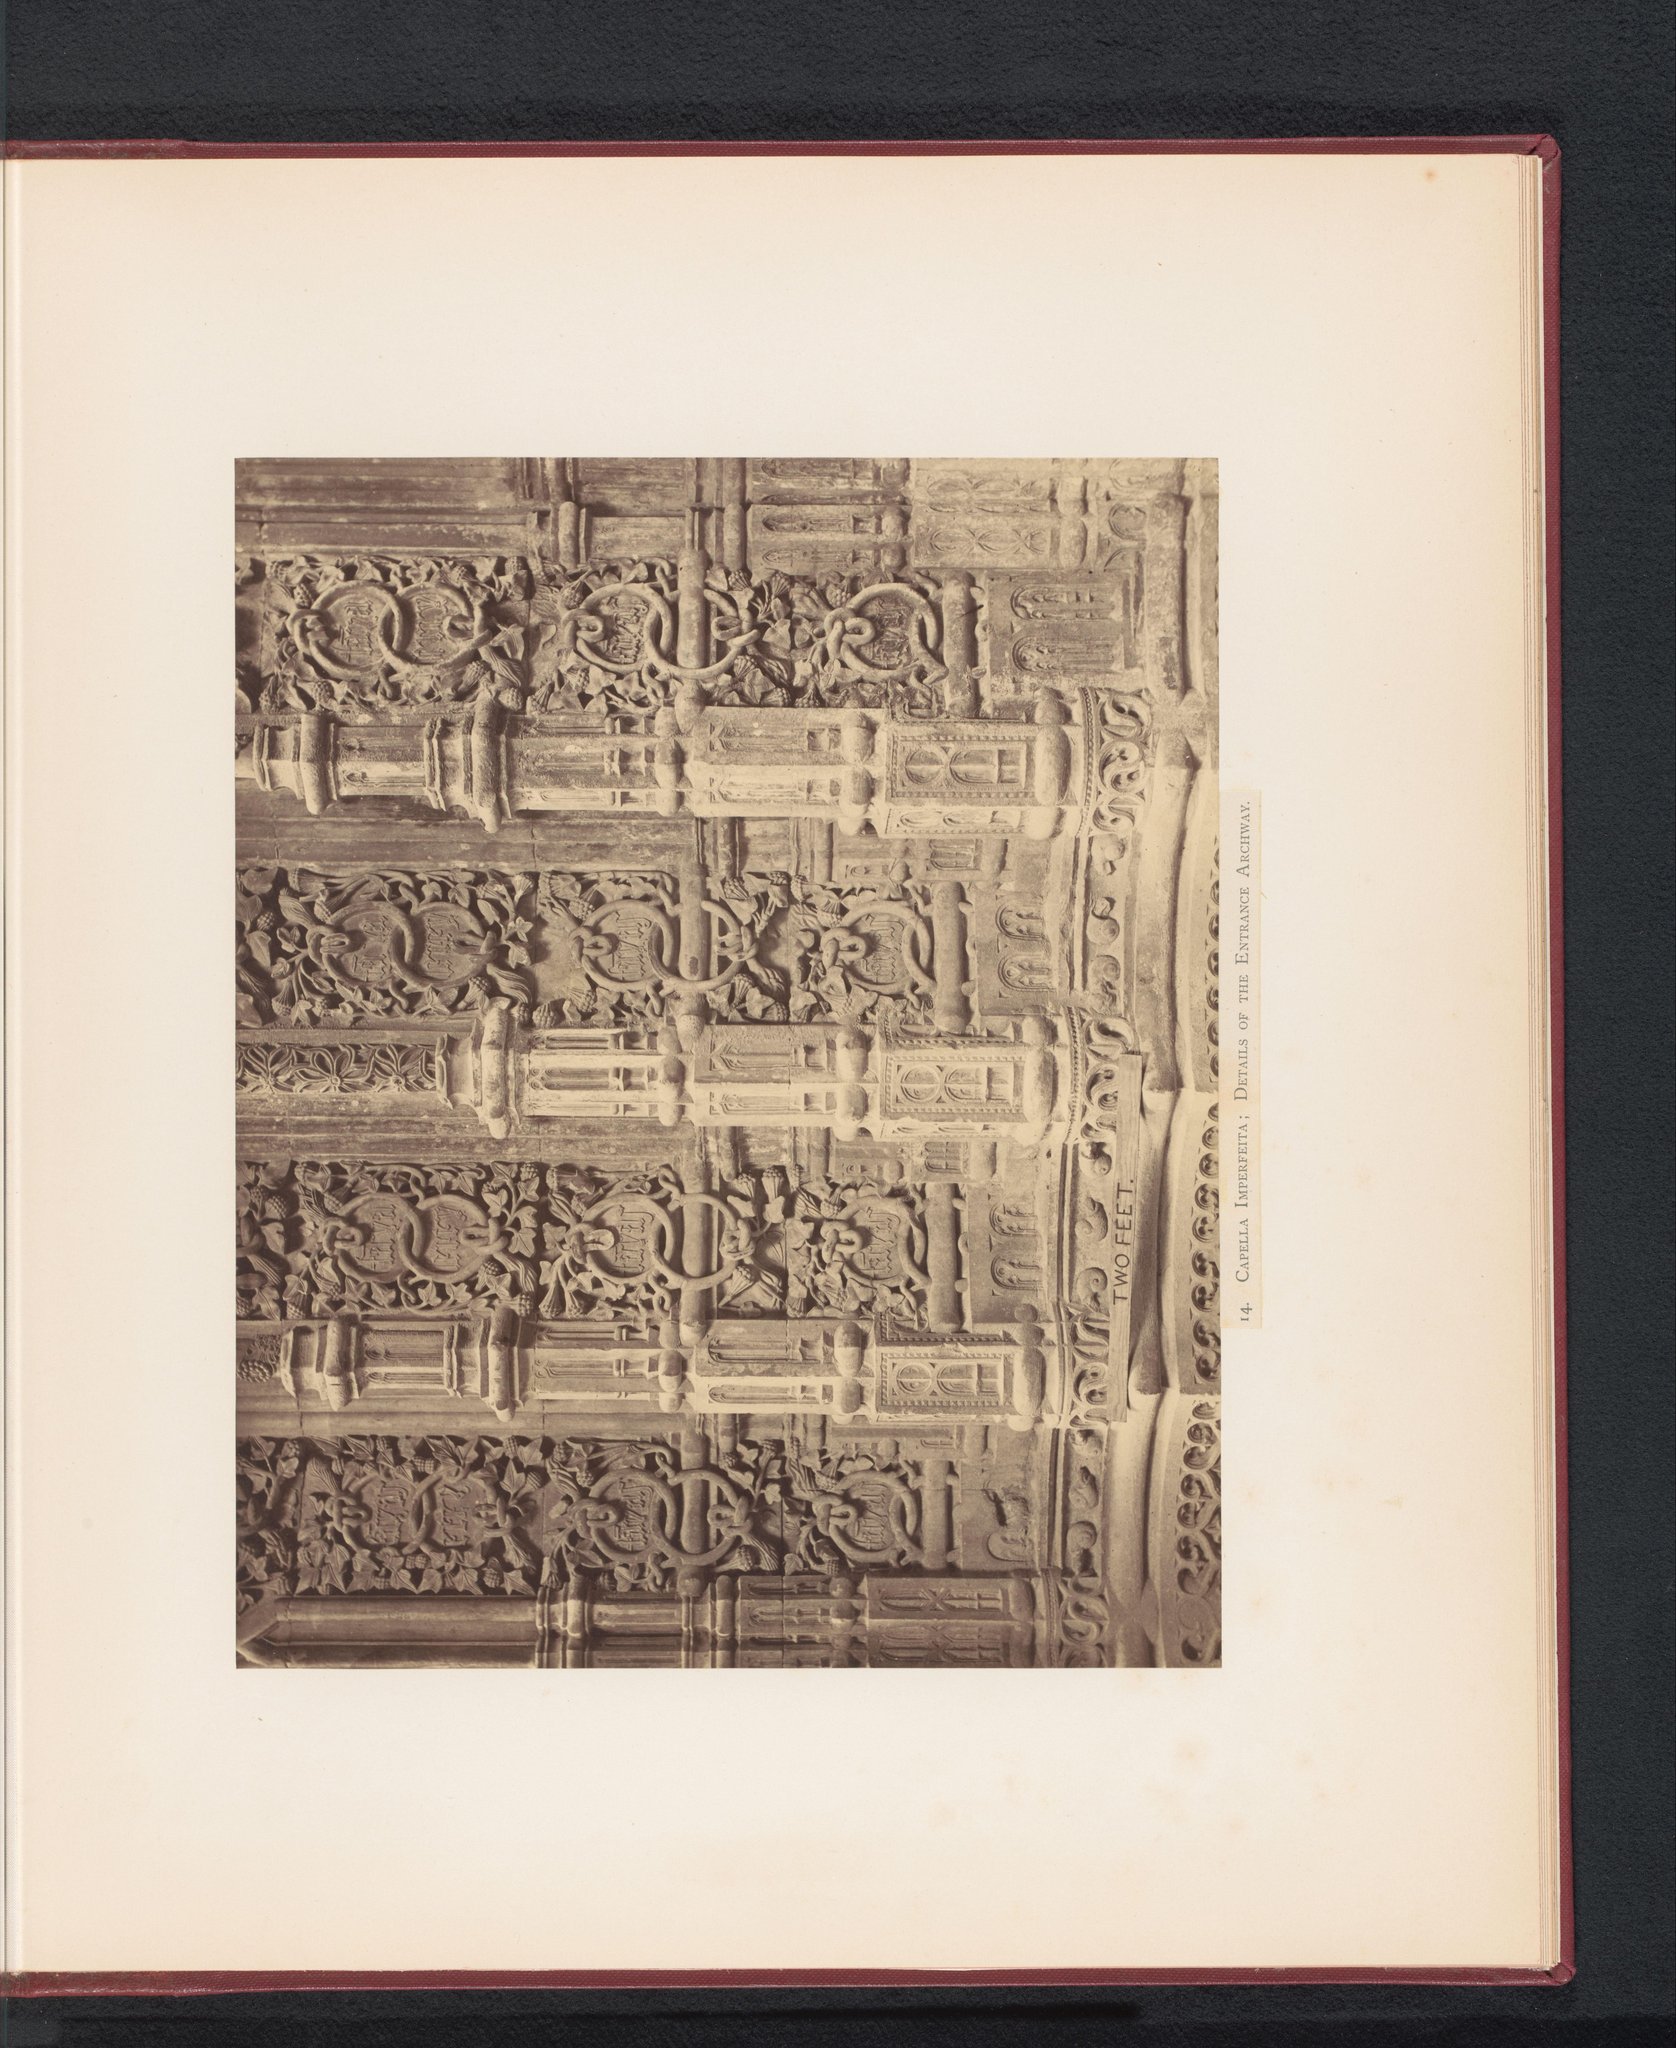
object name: photograph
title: Gezicht op een detail van de toegangsboog van het klooster van Batalha, Portugal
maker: charles thurston thompson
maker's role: fotograaf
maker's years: 1816-1868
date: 1863-1868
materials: photographic support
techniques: albumen print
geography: batalha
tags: arch, archivolt ~ architecture, cloisters ~ monastery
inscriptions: number: ‘14.’